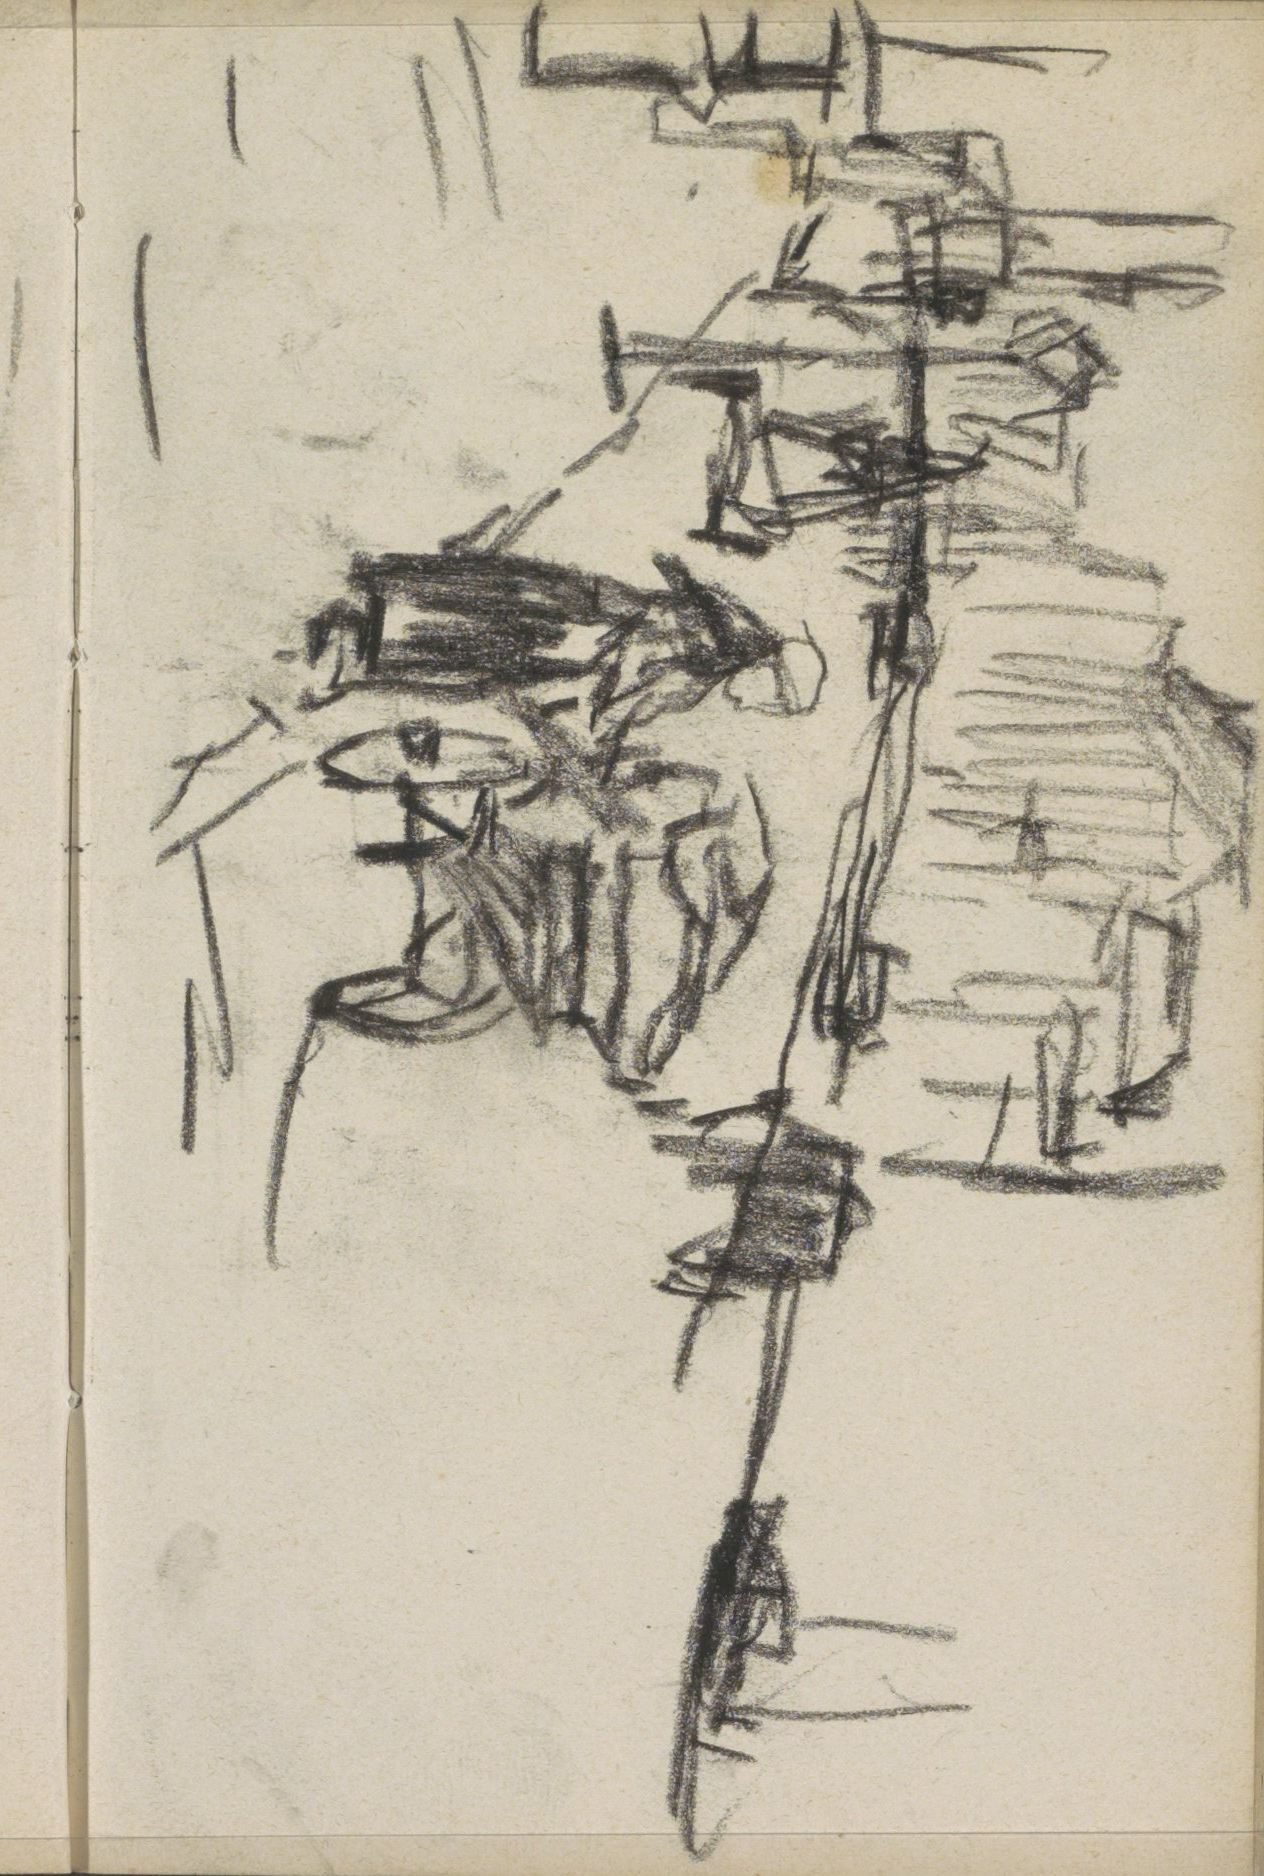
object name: sketchbook leaf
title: Koopvrouw bij haar kar op het Rokin te Amsterdam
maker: george hendrik breitner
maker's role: draughtsman, painter, print maker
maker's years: 1857-1923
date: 1900-1923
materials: chalk, paper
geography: amsterdam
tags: hand-cart, merchant, salesman - bb - women engaged in trade and commerce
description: Pagina 44 uit een schetsboek met 39 bladen.